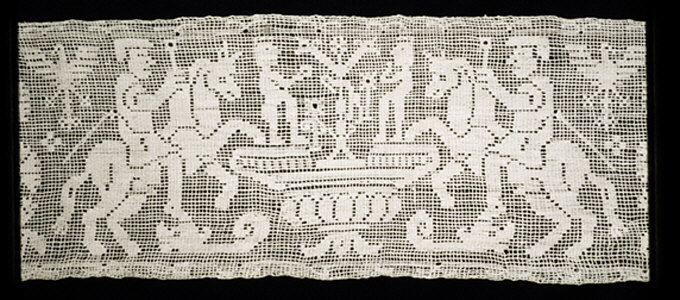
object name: border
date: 1601-1700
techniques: embroidery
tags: horses